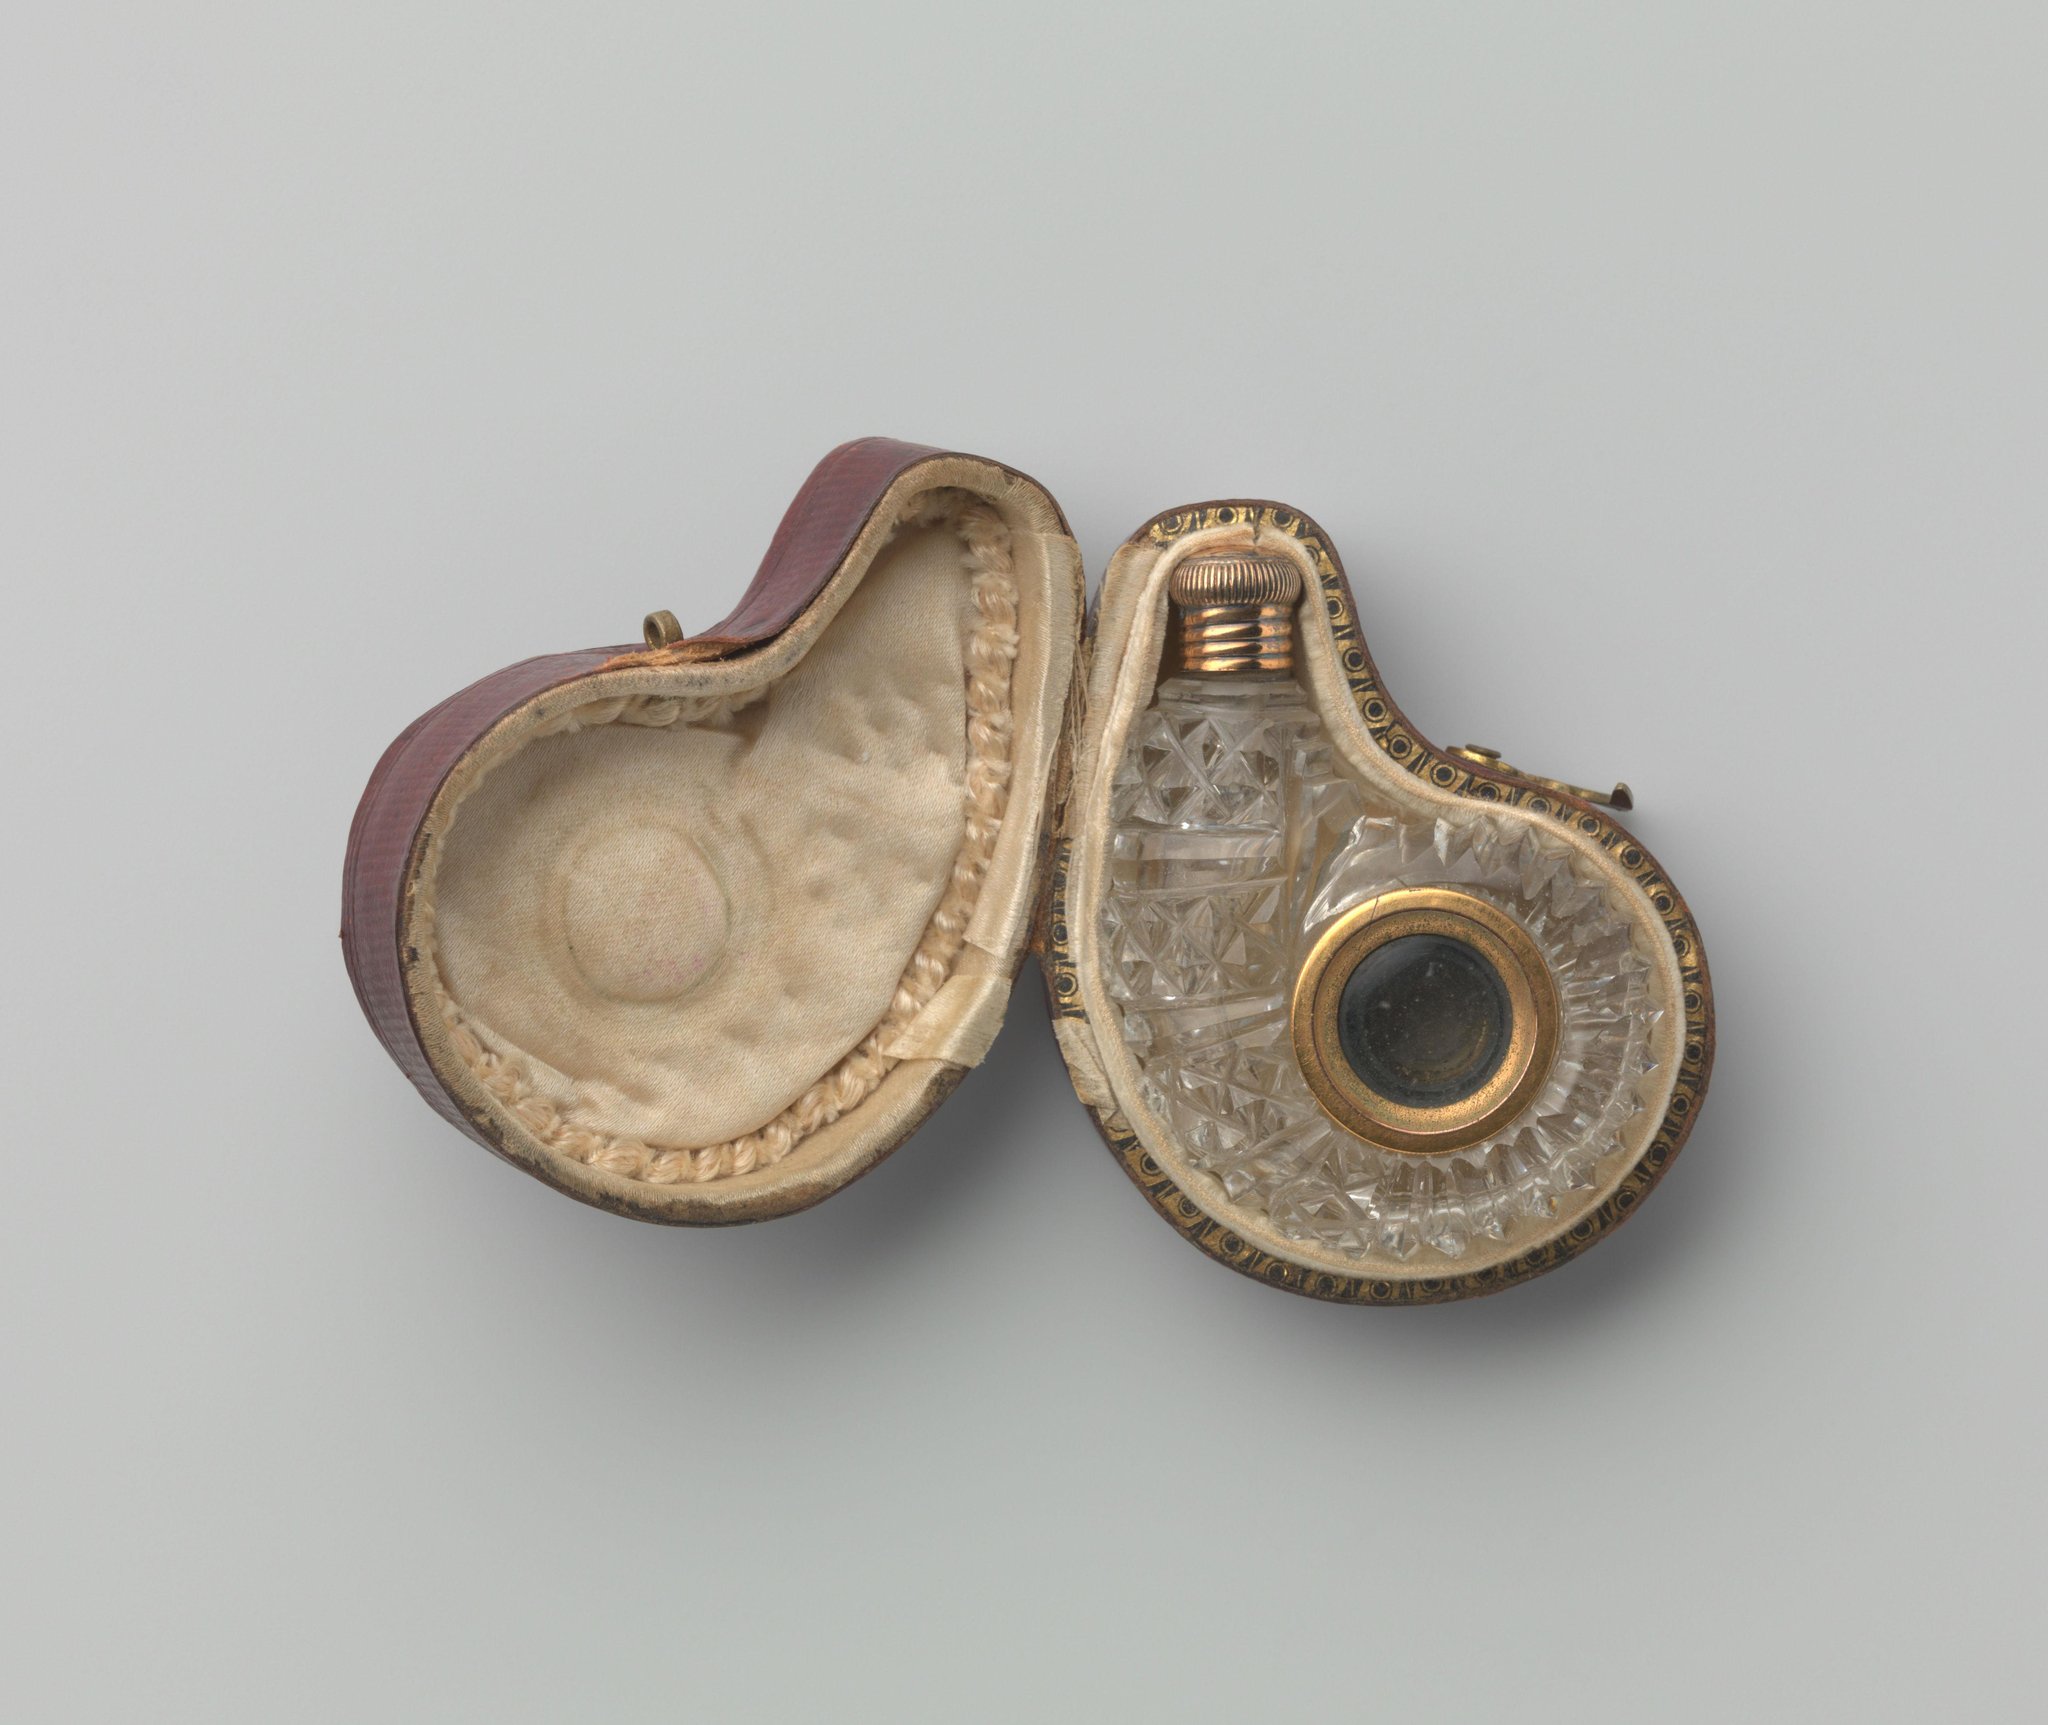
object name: case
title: Foedraal met kristallen fles met gouden dop, tevens toneelkijker, en recu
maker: Anonymous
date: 1700-1800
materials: crystal, gold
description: Foedraal met kristallen fles met gouden dop, tevens toneelkijker, en recu